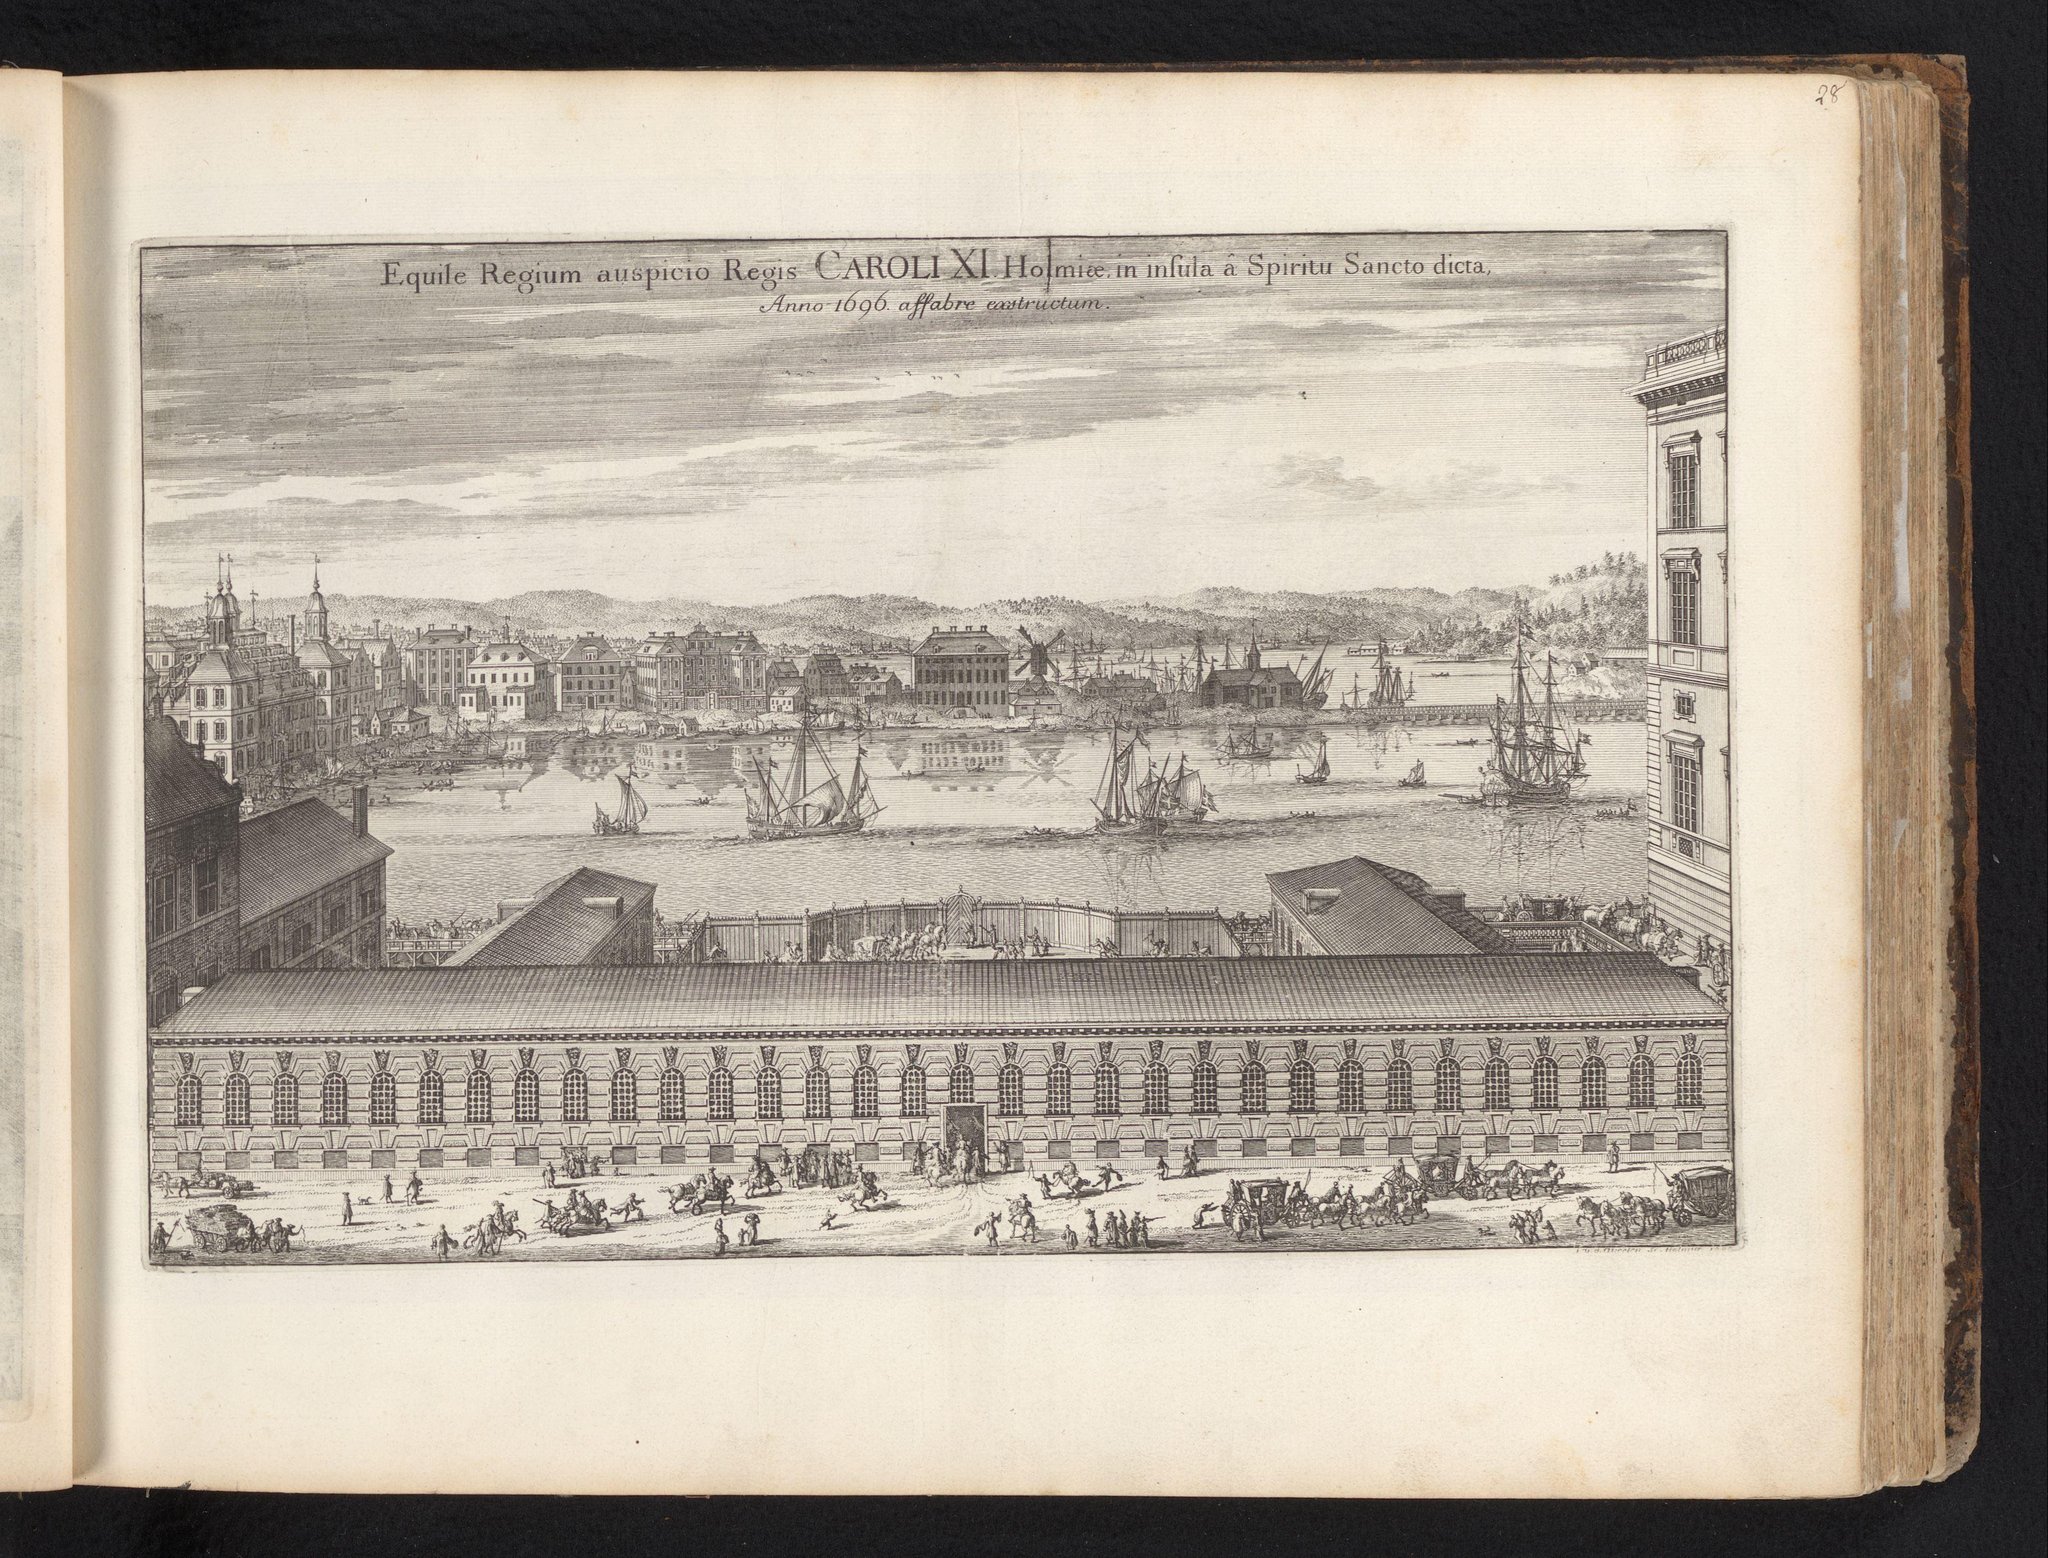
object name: album leaf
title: Suecia Antiqua et Hodierna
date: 1698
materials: paper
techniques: etching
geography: stockholm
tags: ships (in general), stall, stable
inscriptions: date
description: Koninklijke stallen van Karel XI, gebouwd op Helgeandsholmen in Stockholm. Daarachter schepen op het water. De prent maakt deel uit van een album.